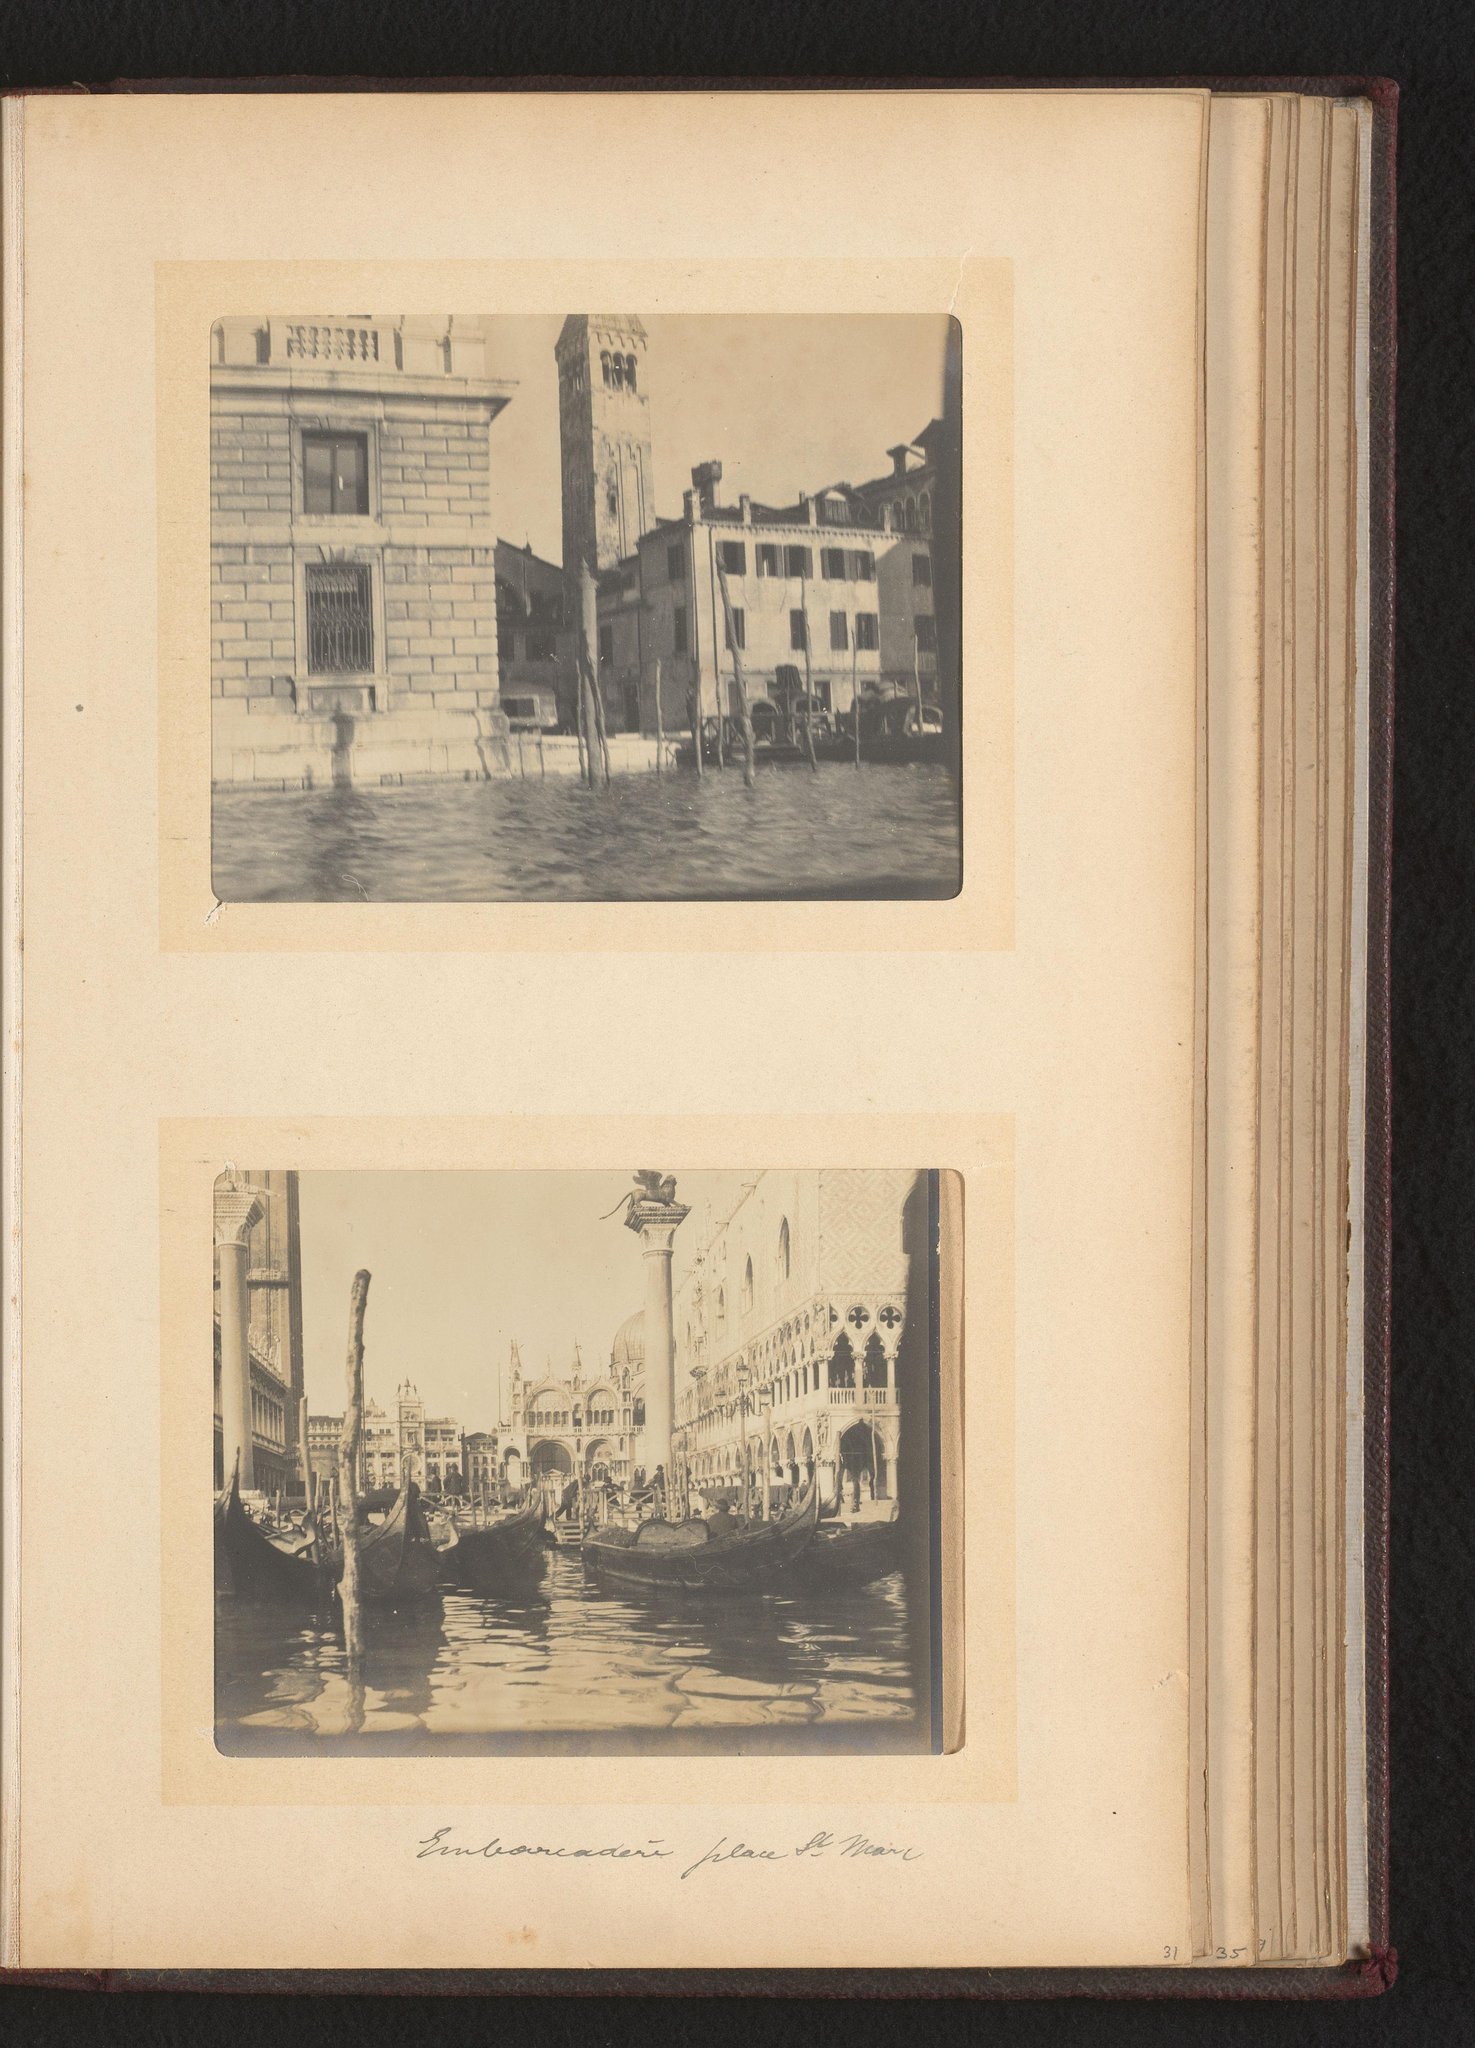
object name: album leaf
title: Kanaal en aanlegsteiger voor gondels bij San Marcoplein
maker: Anonymous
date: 1895-1905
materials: cardboard, photographic support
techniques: gelatin silver print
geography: venice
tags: tourism, gondola, canals, waters (in city) (+ city(-scape) with figures, staffage), venice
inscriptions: inscription: ‘Embarcaderi place St. Marc’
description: Albumblad met twee foto's in Venetië. Onderdeel van een fotoalbum van een reis door Italië, ca. 1900.